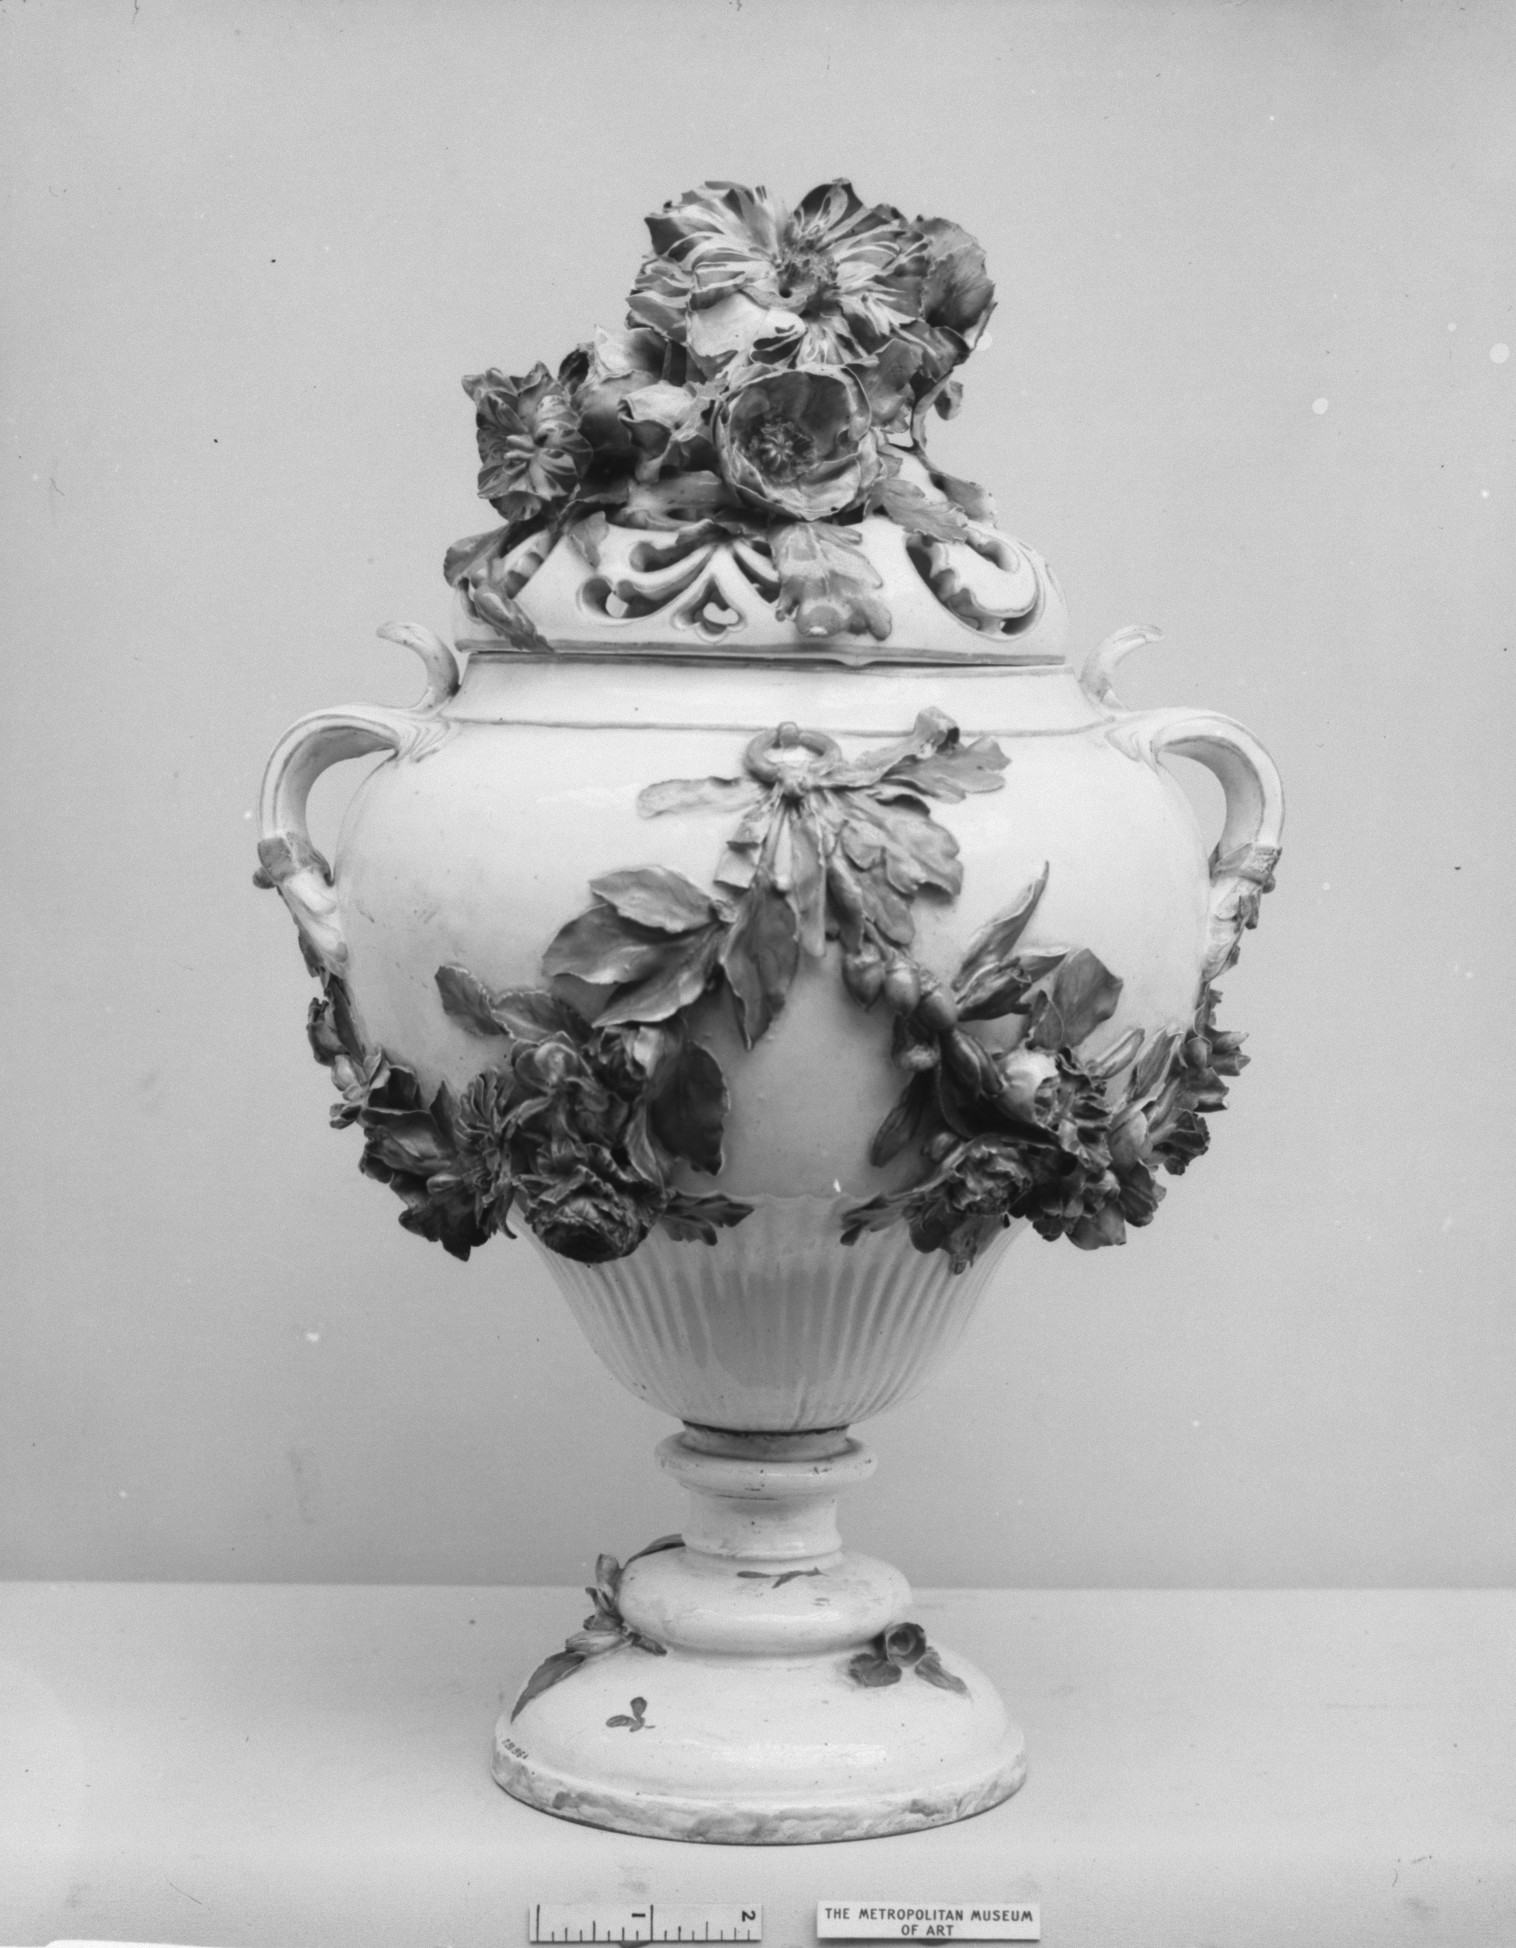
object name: perfume burner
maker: sceaux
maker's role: manufactory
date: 1753-1795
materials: faience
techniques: glazing